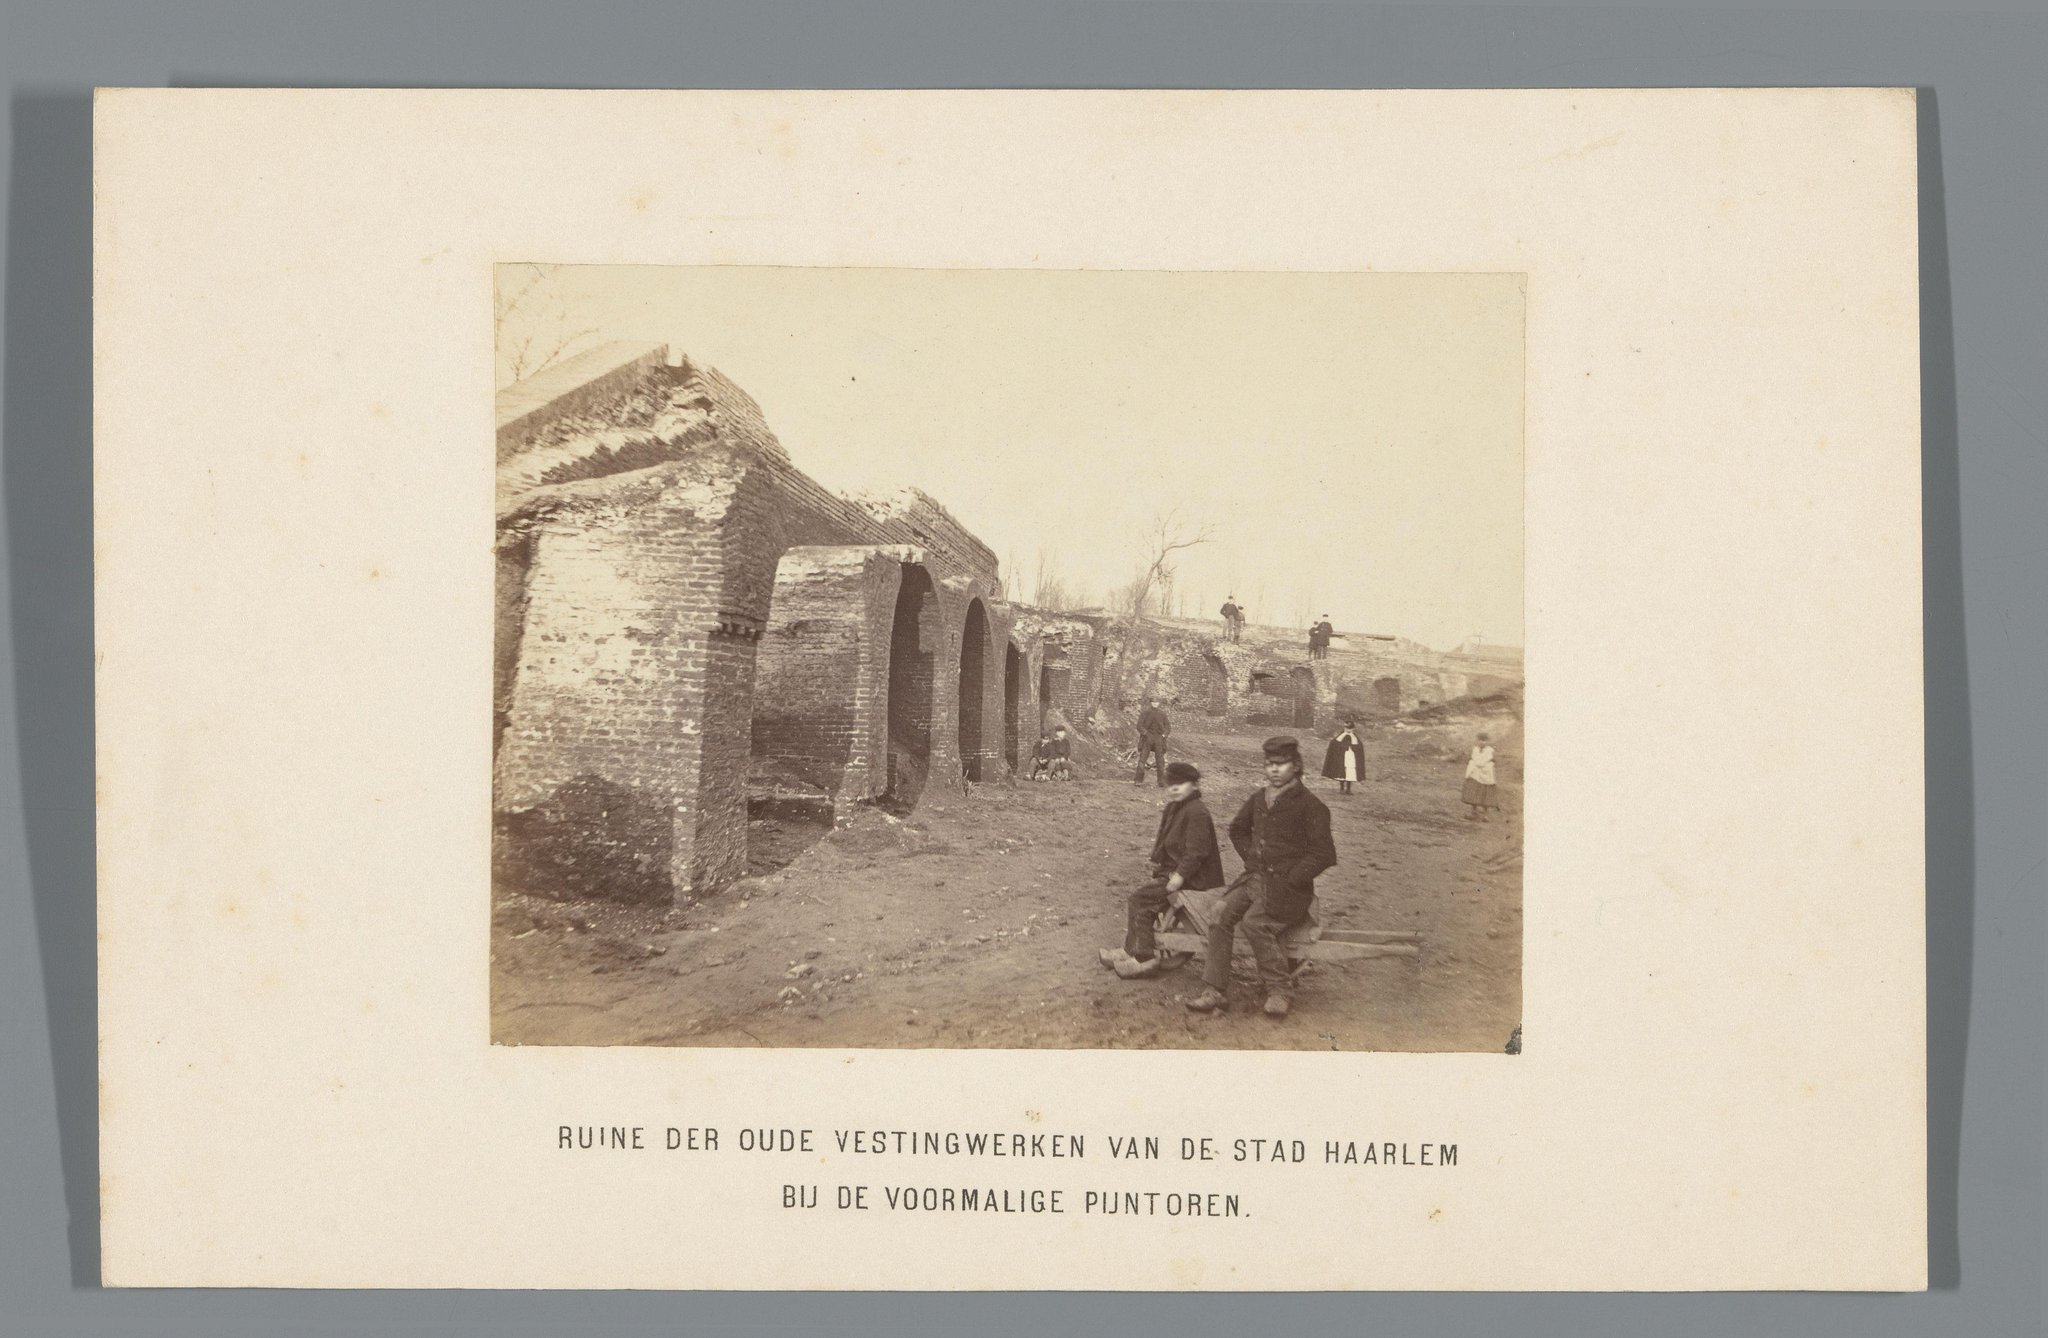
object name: photograph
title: Ruïne van de oude vestingwerken Haarlem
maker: Anonymous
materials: photographic support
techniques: albumen print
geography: haarlem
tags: haarlem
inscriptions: inscription: ‘Ruïne der oude vestingwerken van de stad Haarlem bij de voormalige Pijntoren’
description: Ruïne van de oude vestingwerken Haarlem met zittende figuren op de voorgrond.